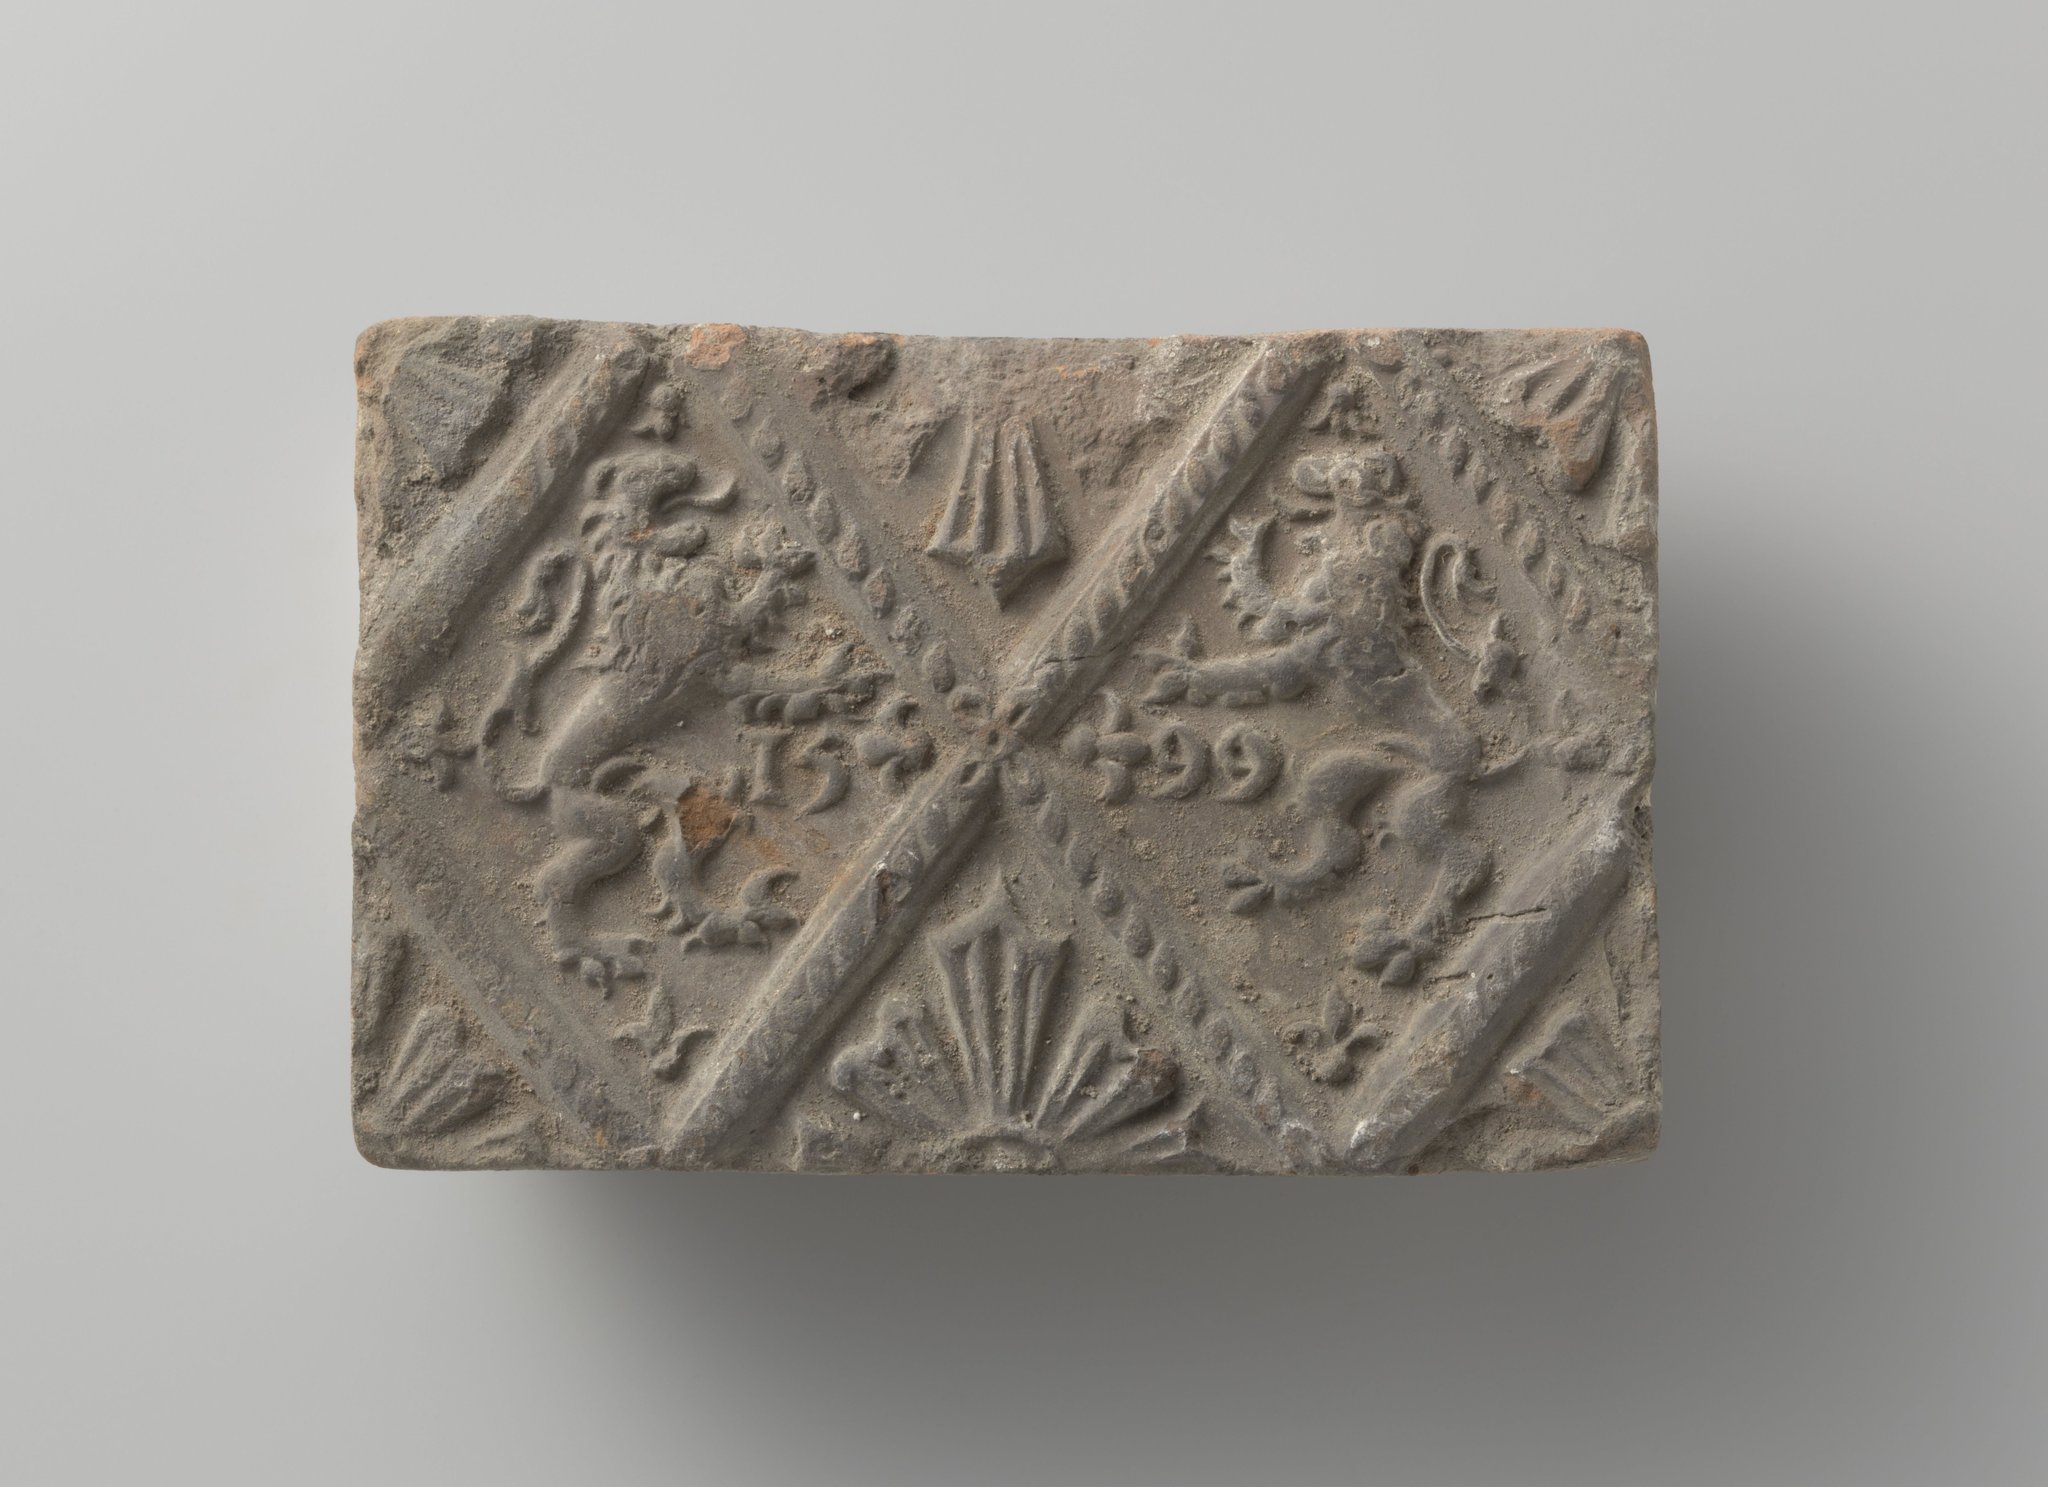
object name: hearthstone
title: Haardsteen met voorstelling van twee klimmende leeuwen, geplaatst in twee ruiten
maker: Anonymous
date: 1599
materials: earthenware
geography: southern netherlands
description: Haardsteen van gebakken aarde met ruitvormige verdeling. In elke twee ruiten: twee naar elkaar toe gekeerde klimmende leeuwen; en in de andere een ruitvormige bloem. Met het jaartal 1599. Met roet doortrokken.